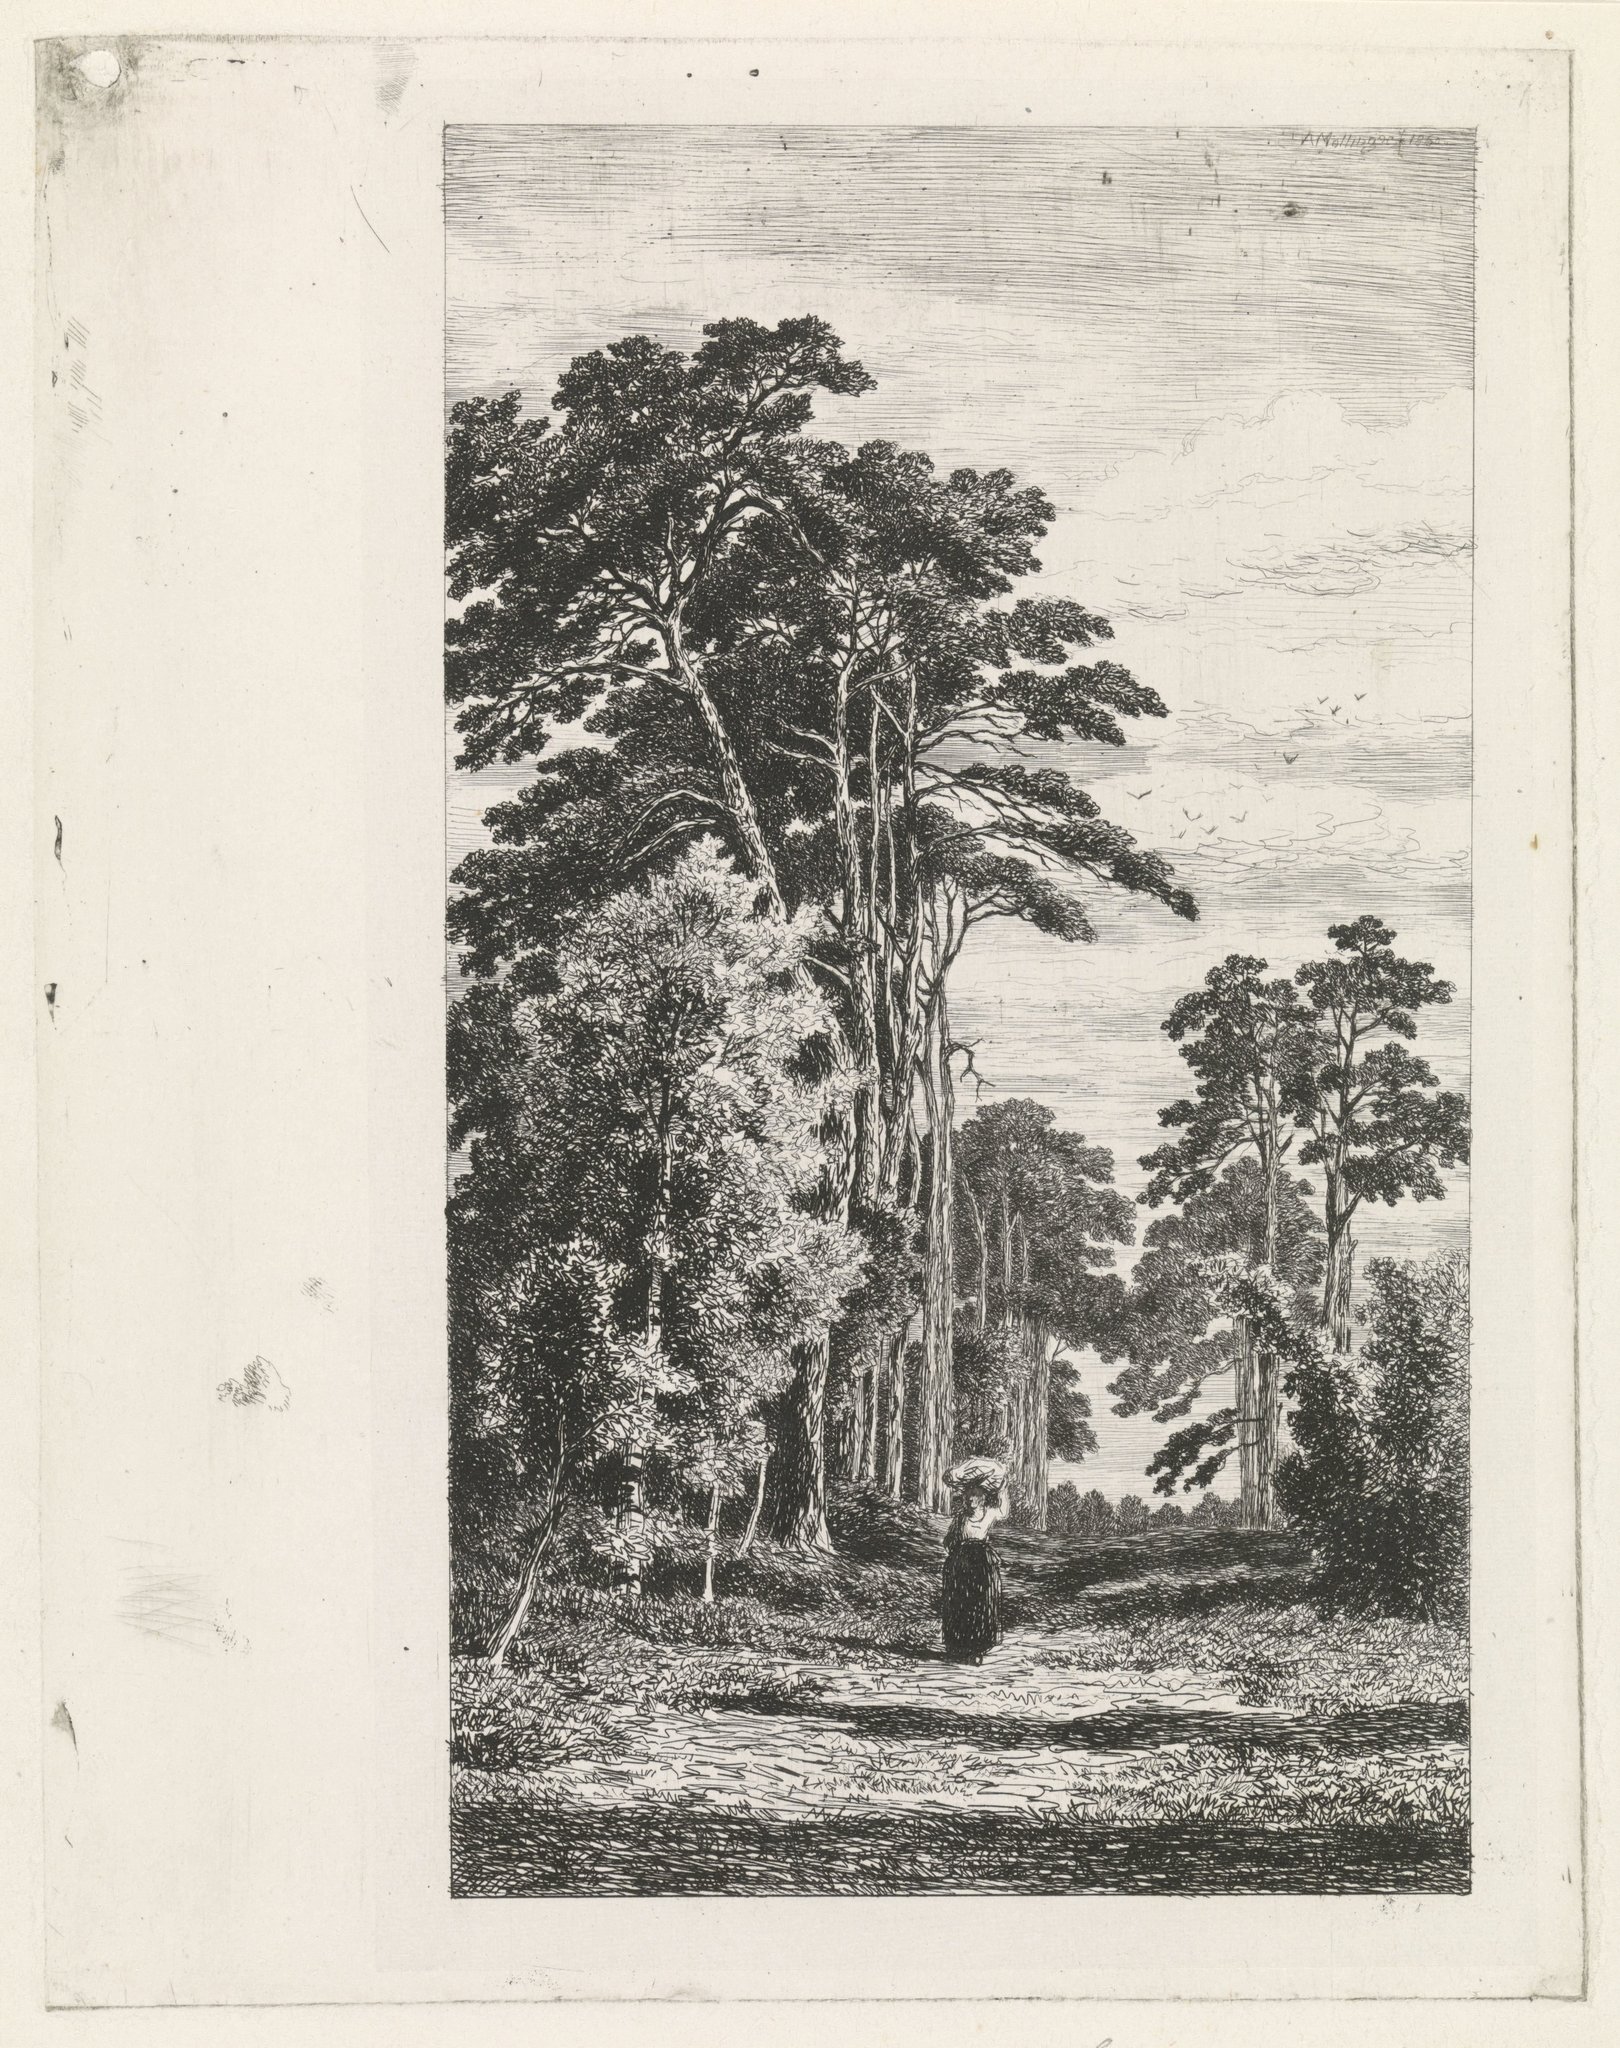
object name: print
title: Dennenlaan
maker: alexander mollinger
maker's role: painter, print maker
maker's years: 1836-1867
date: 1860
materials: paper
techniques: etching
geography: utrecht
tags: trees: pine, carrying something on the head or on the shoulders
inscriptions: collector's mark: Lugt 2228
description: In een dennenlaan loopt een vrouw met een pak op haar hoofd.